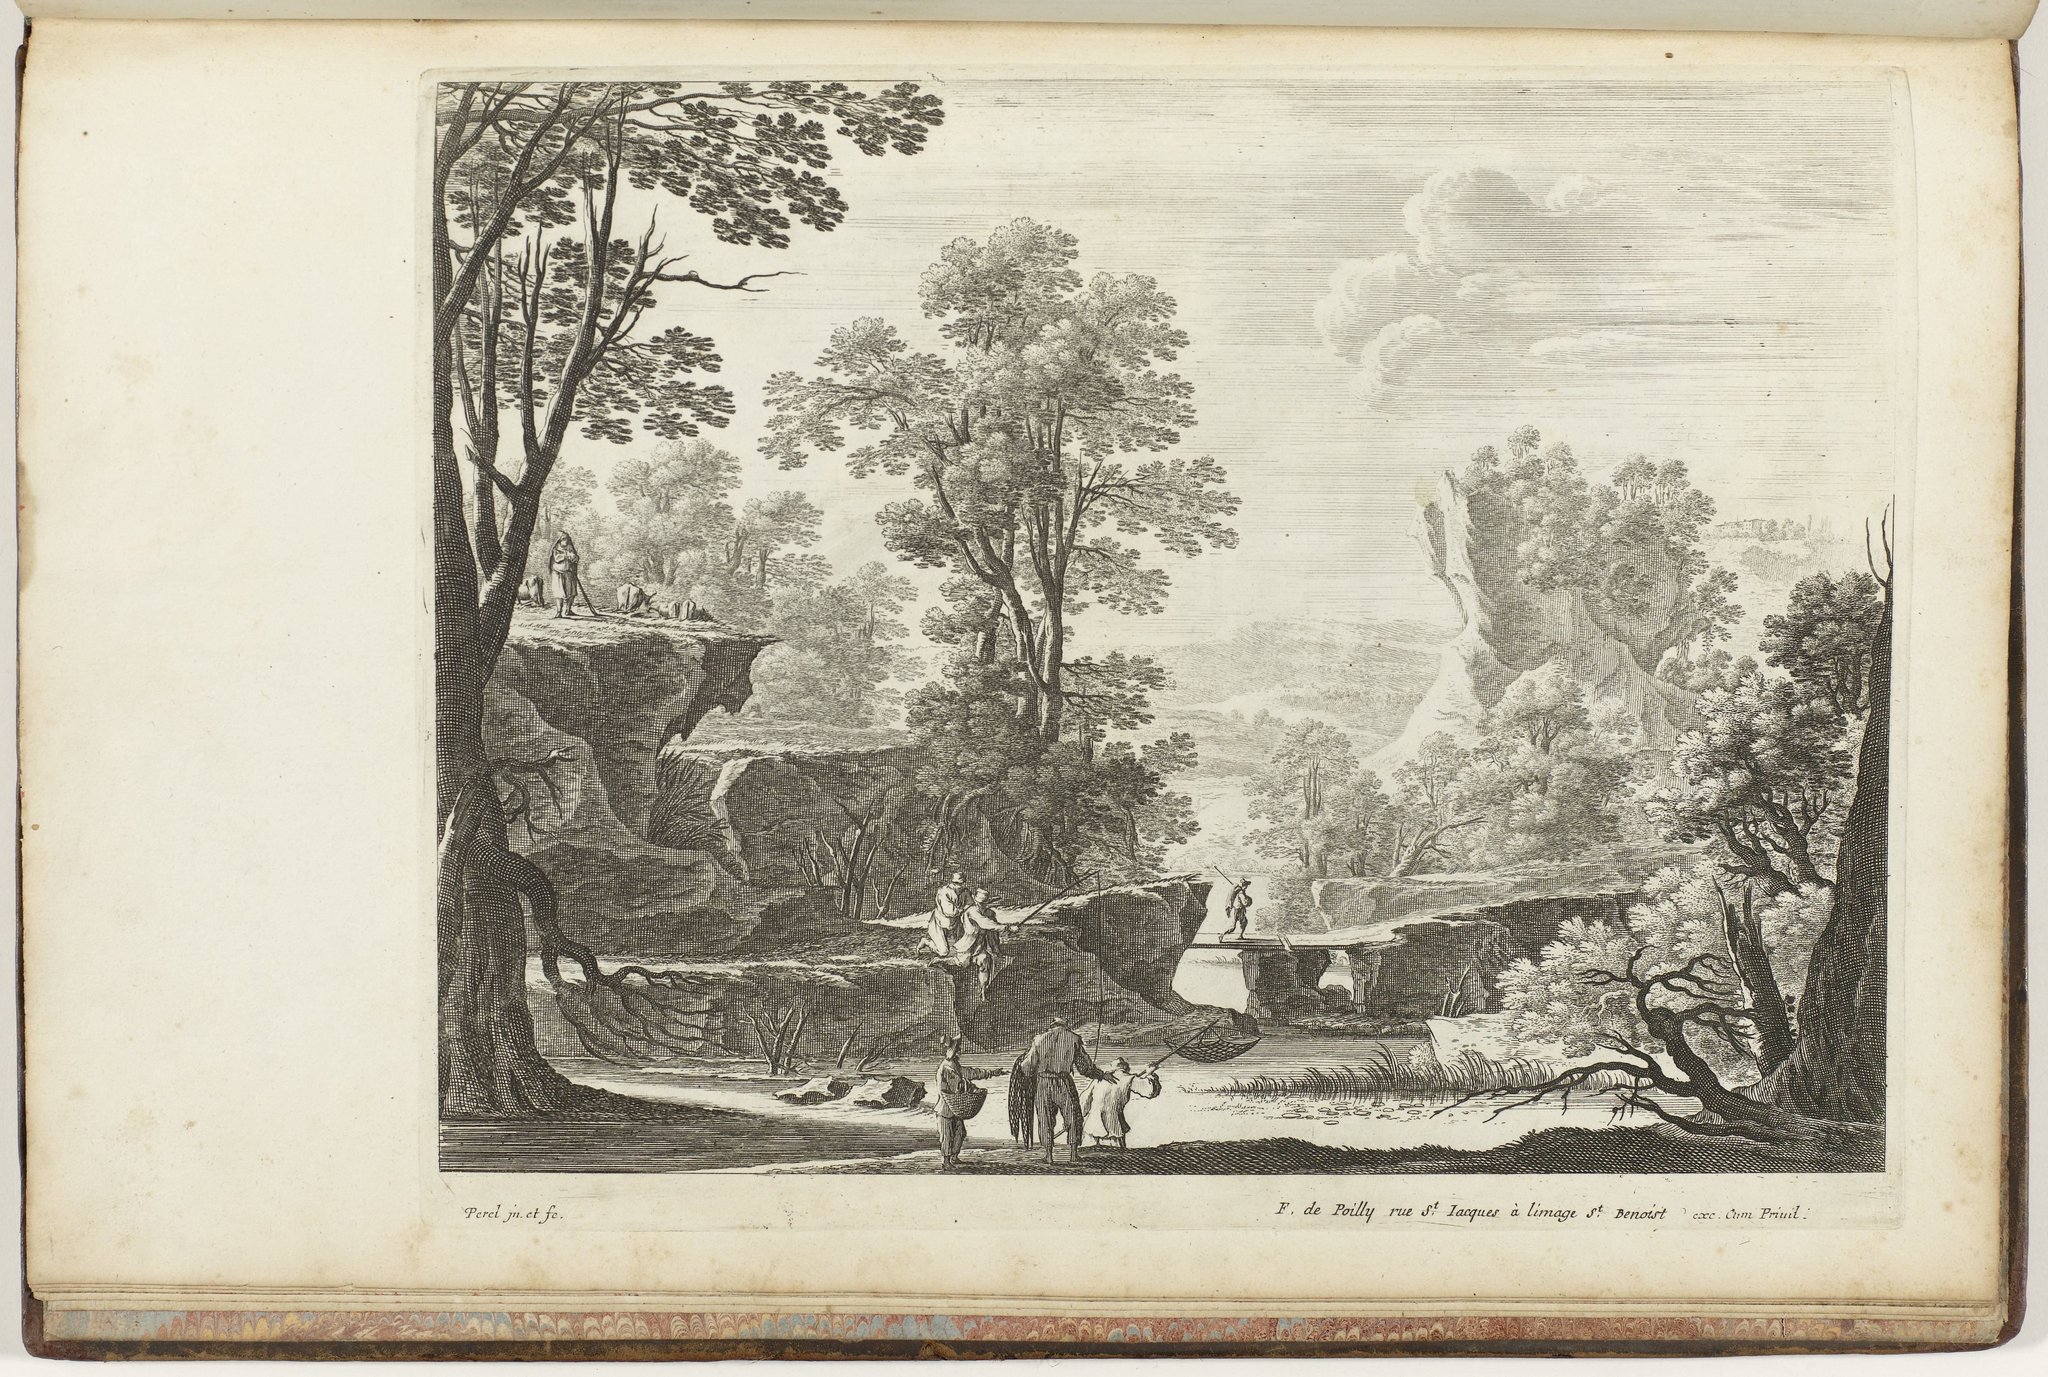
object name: album leaf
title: Landschap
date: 1680-1695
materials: paper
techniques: etching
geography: paris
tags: landscapes in the temperate zone (+ landscape with figures, staffage)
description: Landschap. Ontwerp voor schildering boven schoorsteenmantel of deur? Prent maakt deel uit van een album.